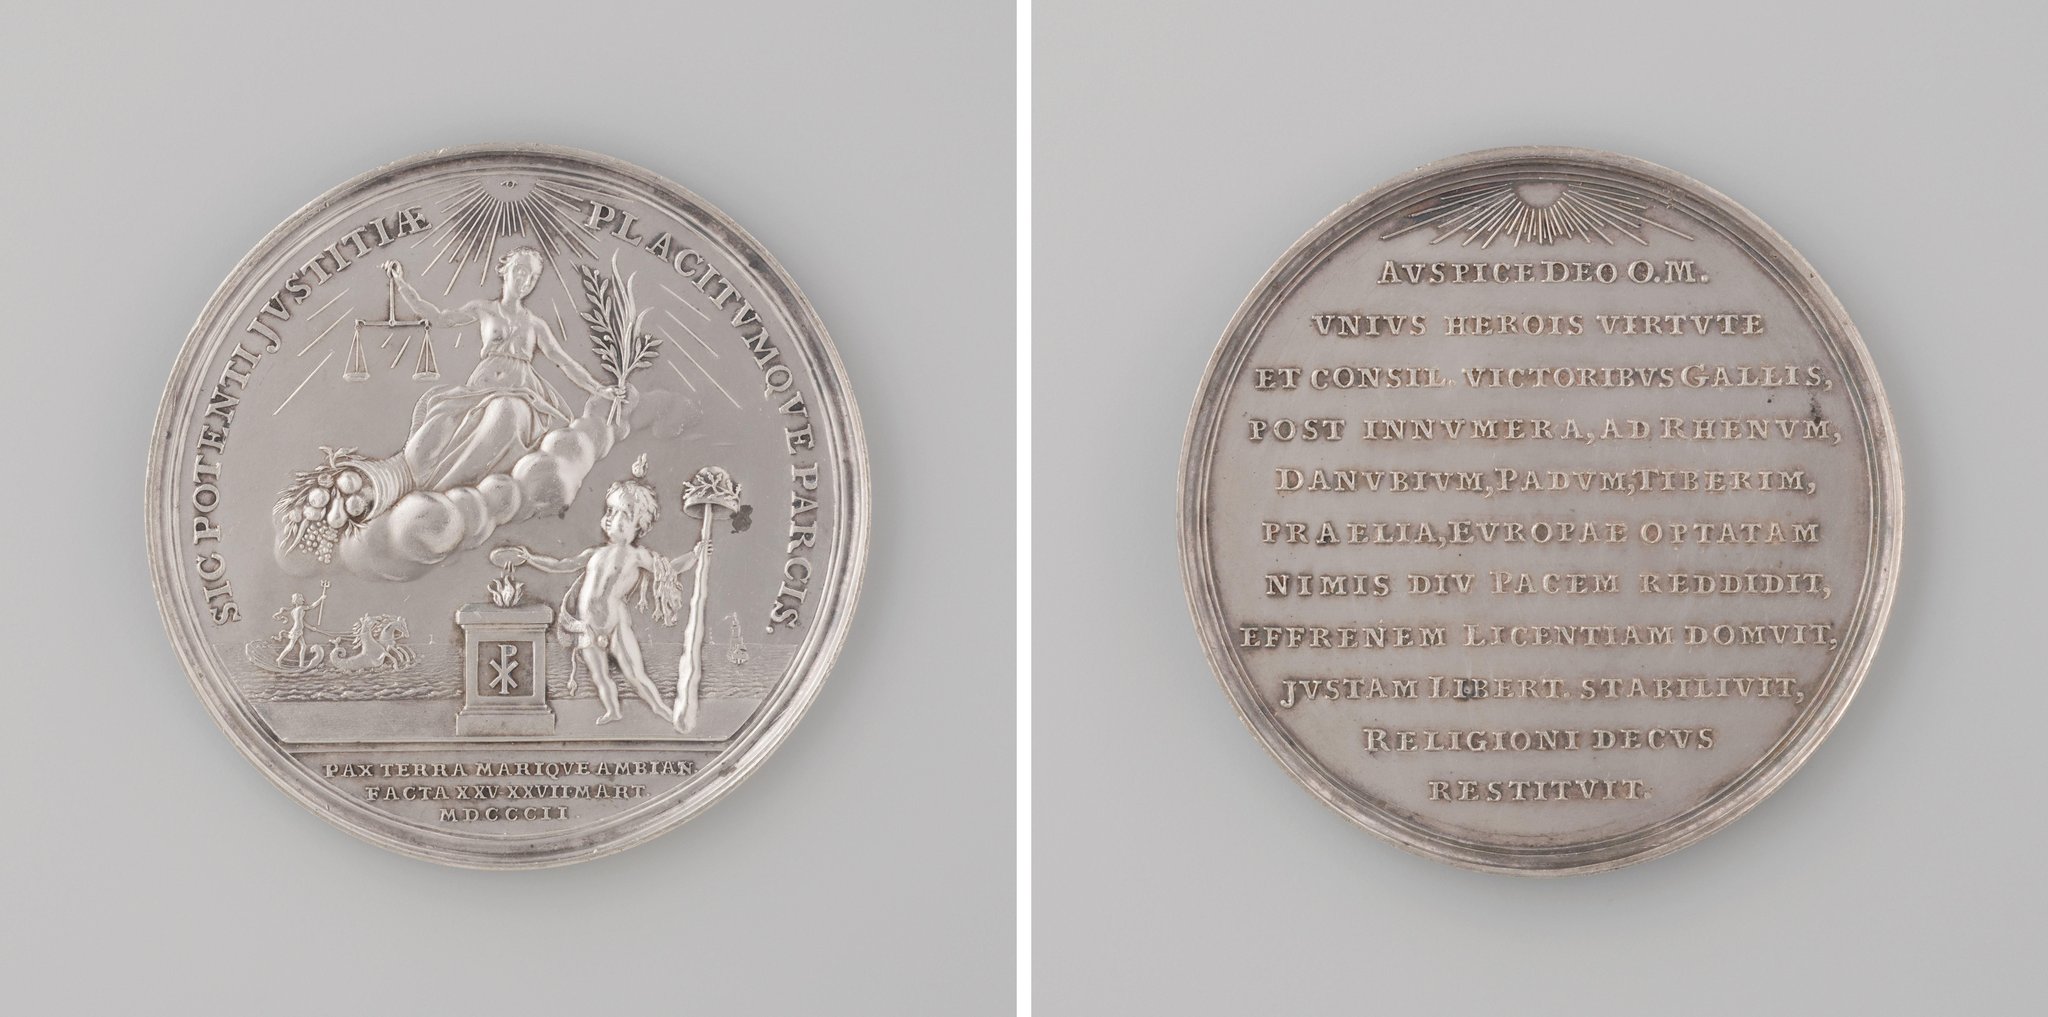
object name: history medal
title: Vrede van Amiens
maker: johan george holtzhey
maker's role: mintmaster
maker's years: 1726-1808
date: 1802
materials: silver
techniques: striking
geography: amsterdam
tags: amiens, vrede van amiens (1802)